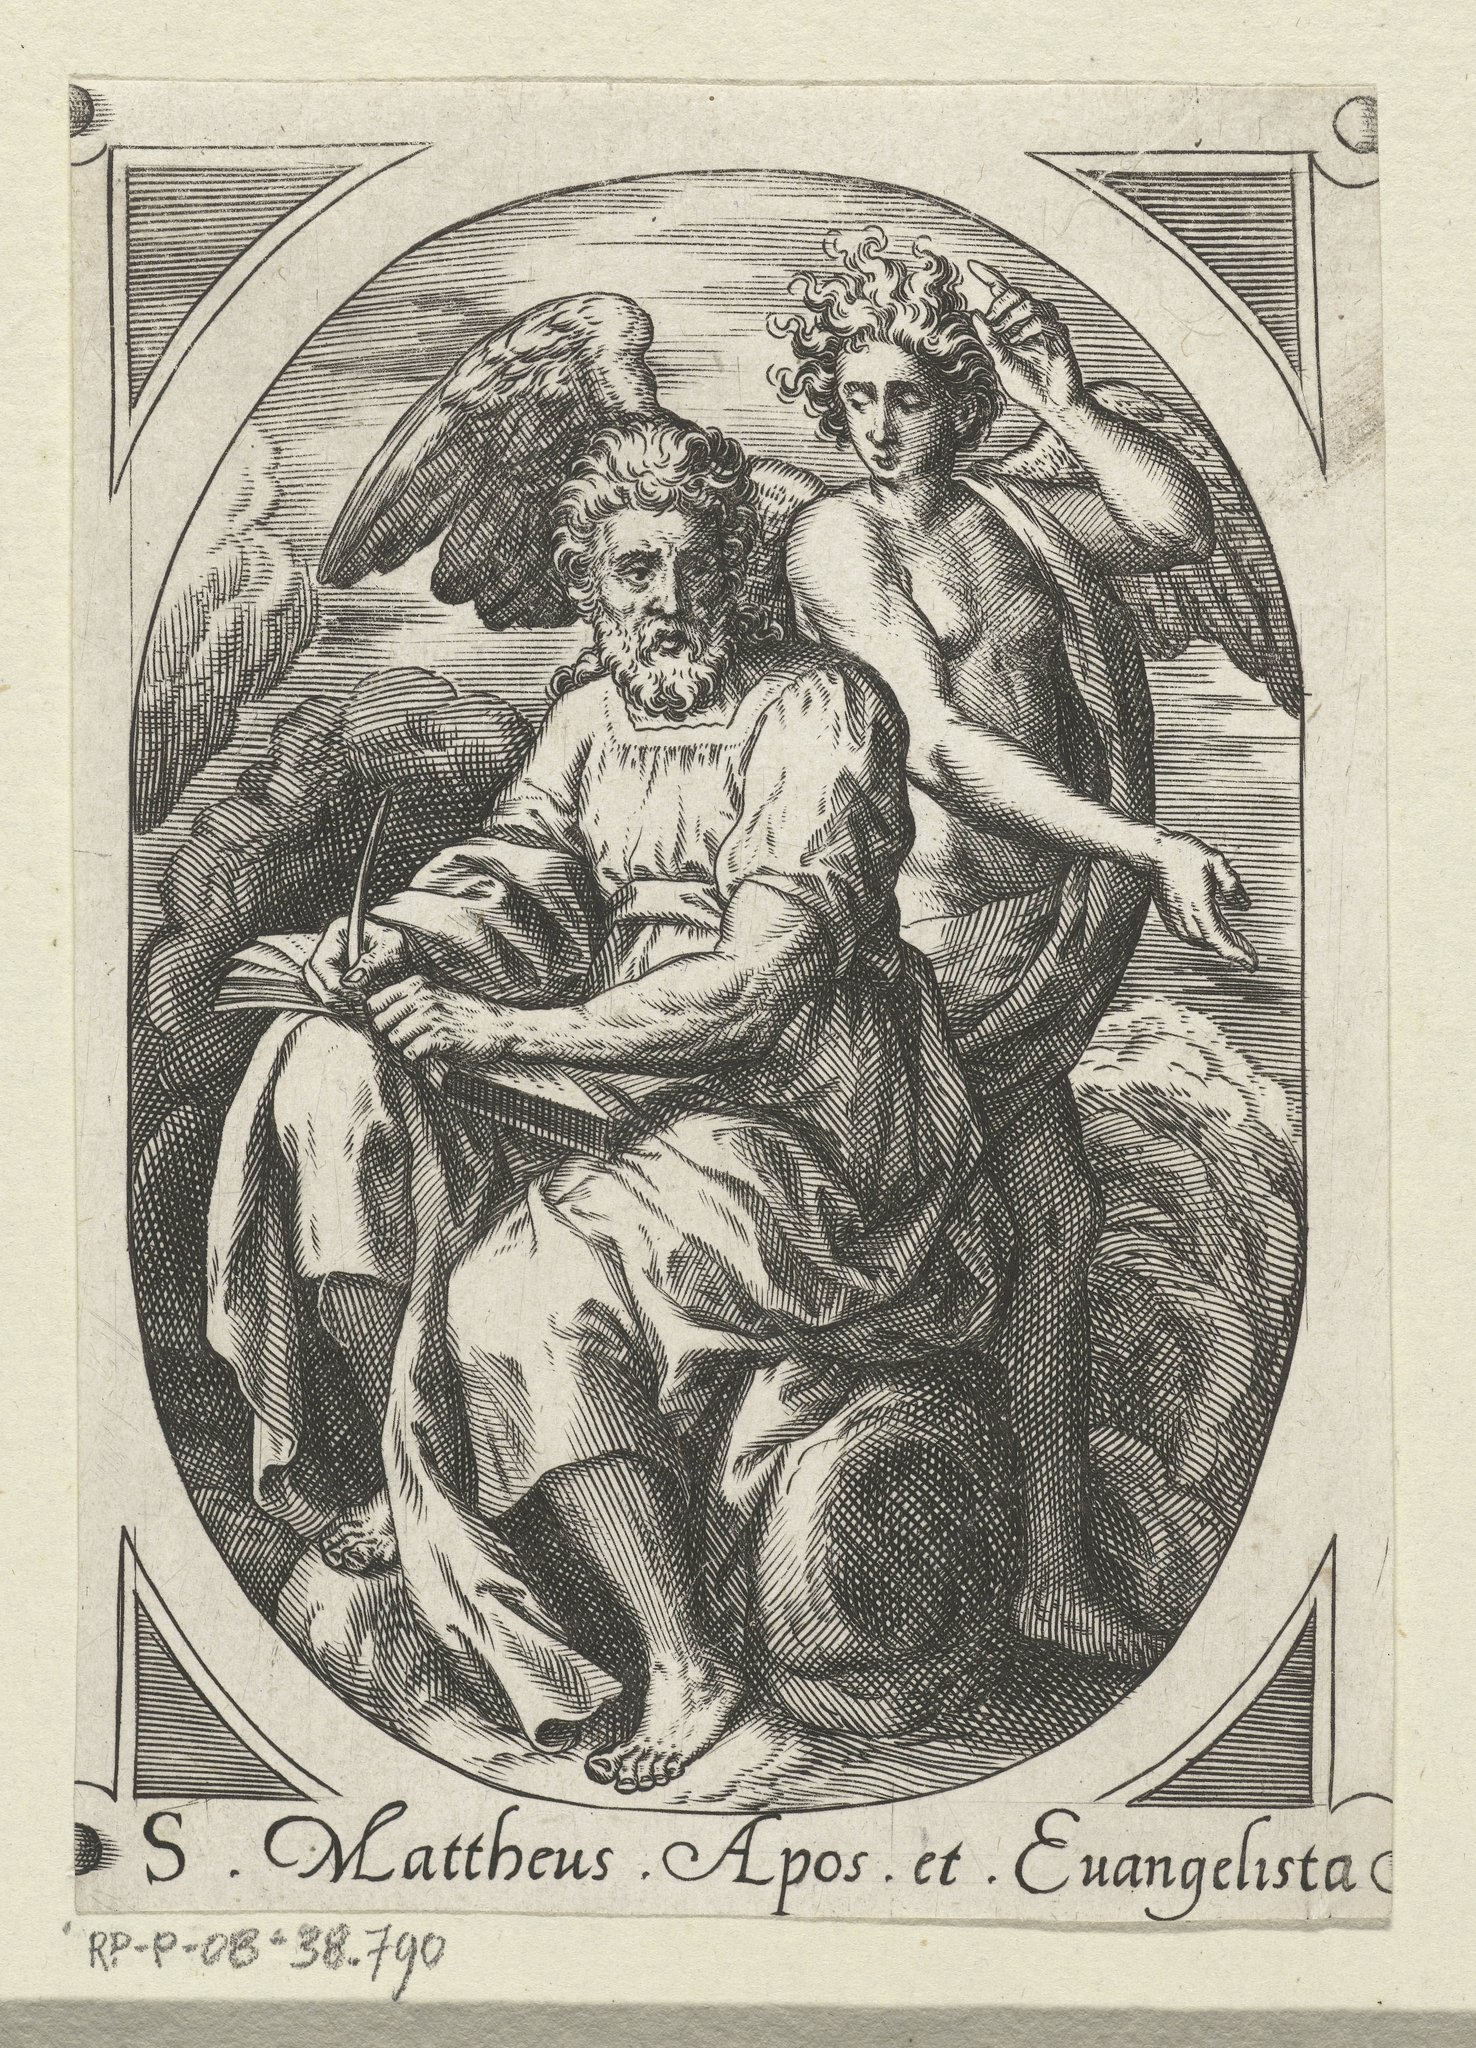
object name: print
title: S. Mattheus Apos et Euangelista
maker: Anonymous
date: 1534-1640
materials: paper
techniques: engraving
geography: italy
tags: the apostle and evangelist matthew (mattheus); possible attributes: angel, axe, book, halberd, pen and inkhorn, purse, scroll, square, sword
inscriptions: collector's mark: Lugt 240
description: Prent naar ontwerp van Crispijn van den Broeck.